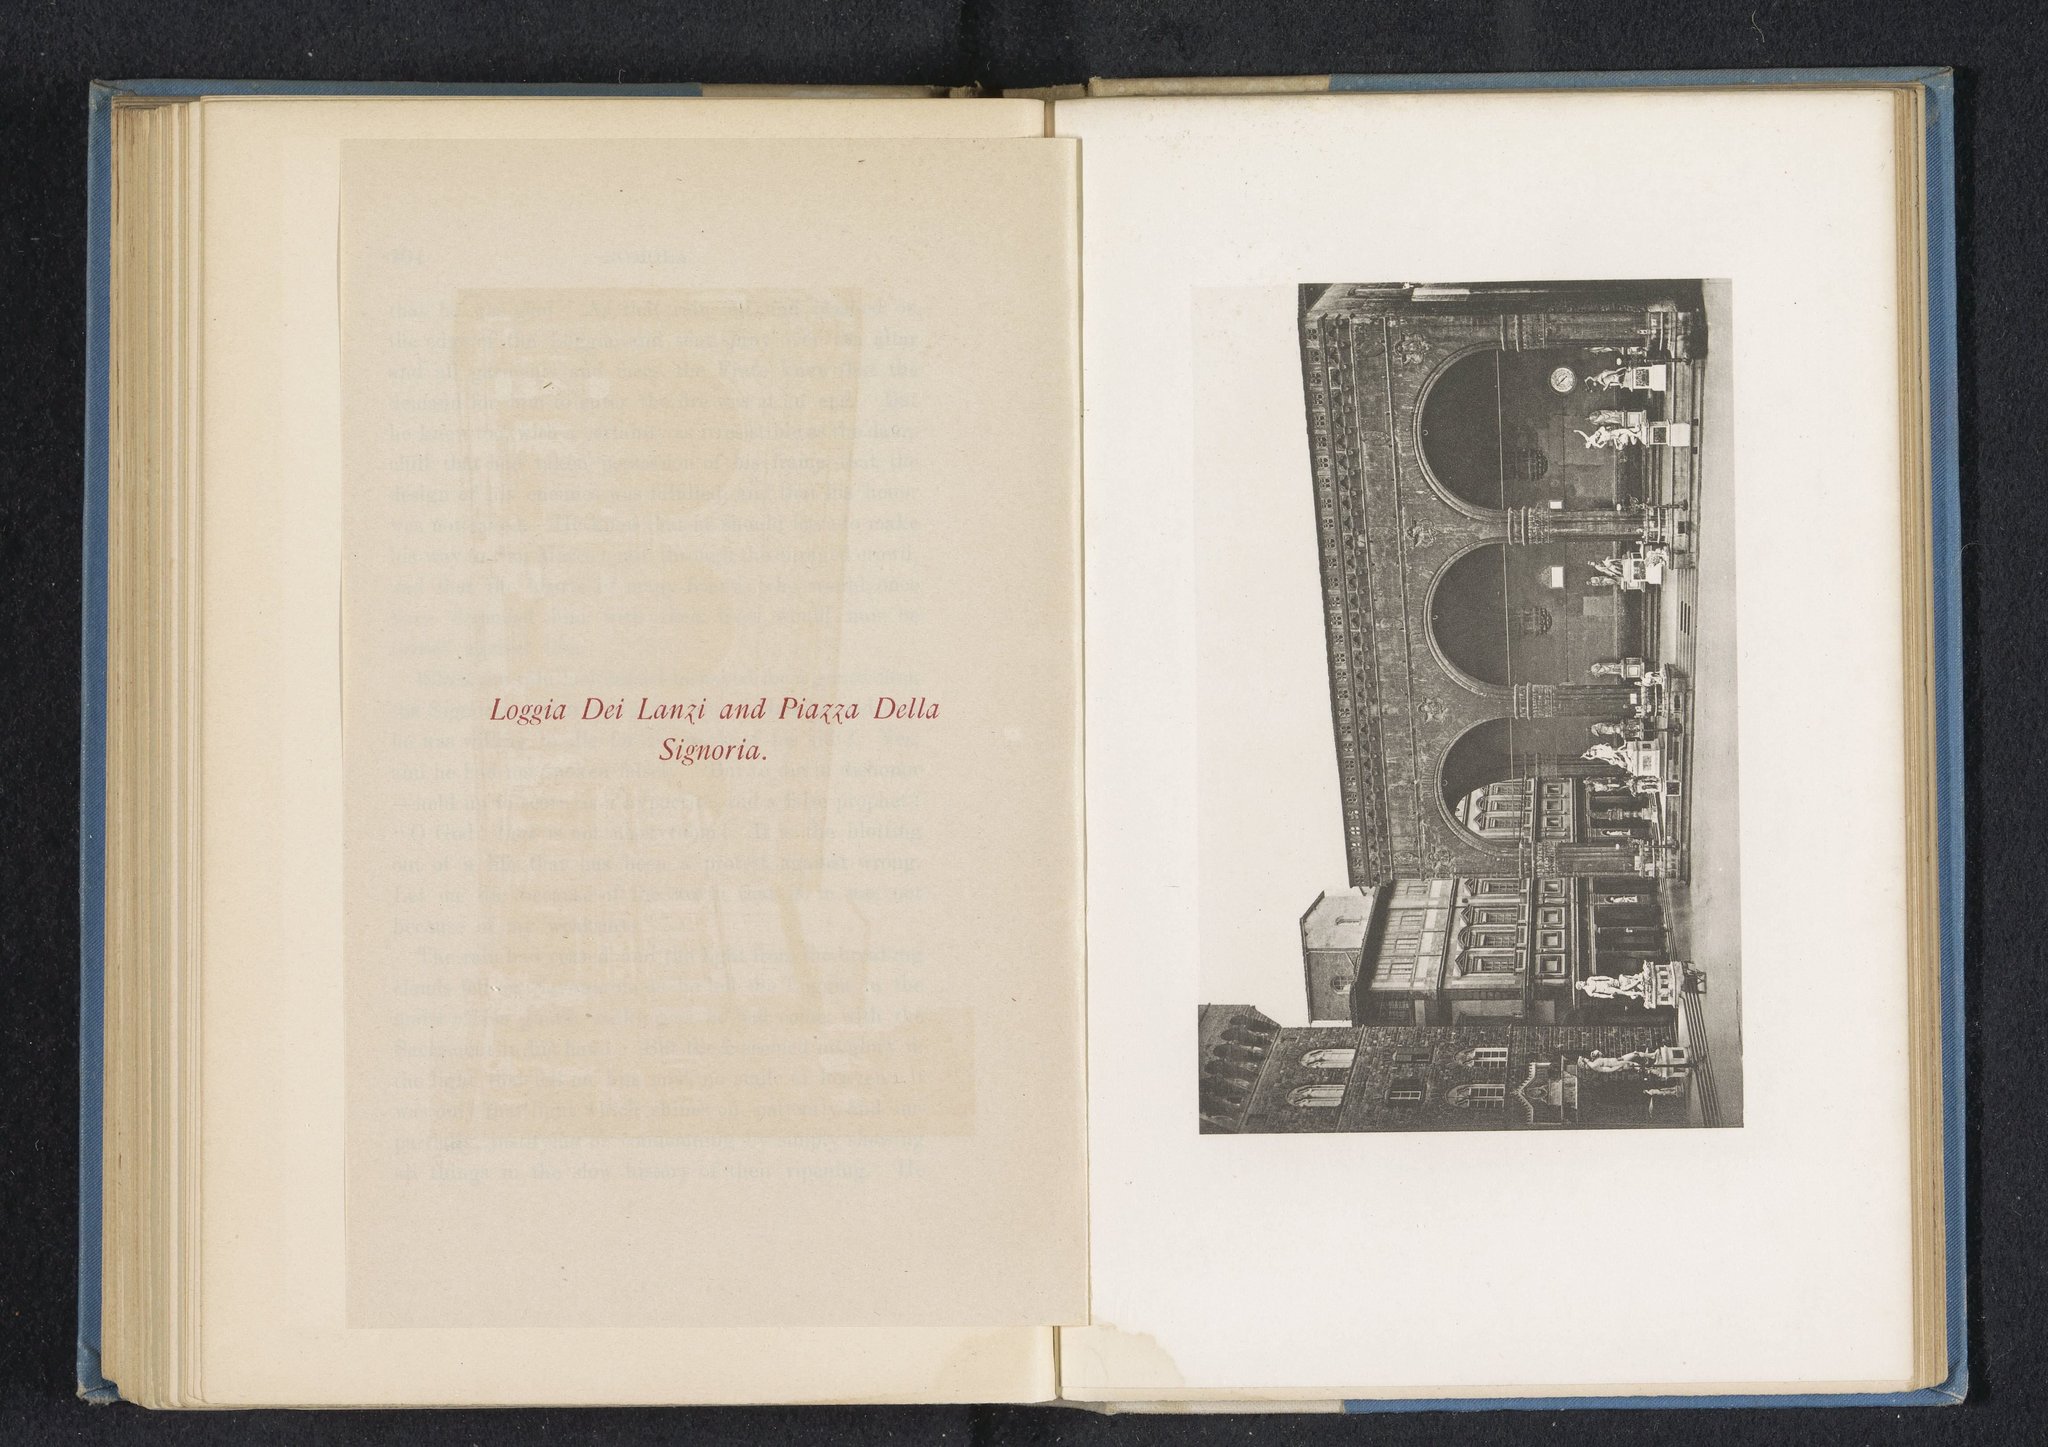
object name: photomechanical print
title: Gezicht op het Piazza della Signoria en de Loggia dei Lanzi te Florence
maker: Anonymous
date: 1880-1890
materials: paper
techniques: photoaquatint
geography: boston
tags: square, place, circus, etc., loggia, verandah, porch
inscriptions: title: ‘Loggia Dei Lanzi and Piazza Della Signoria.’